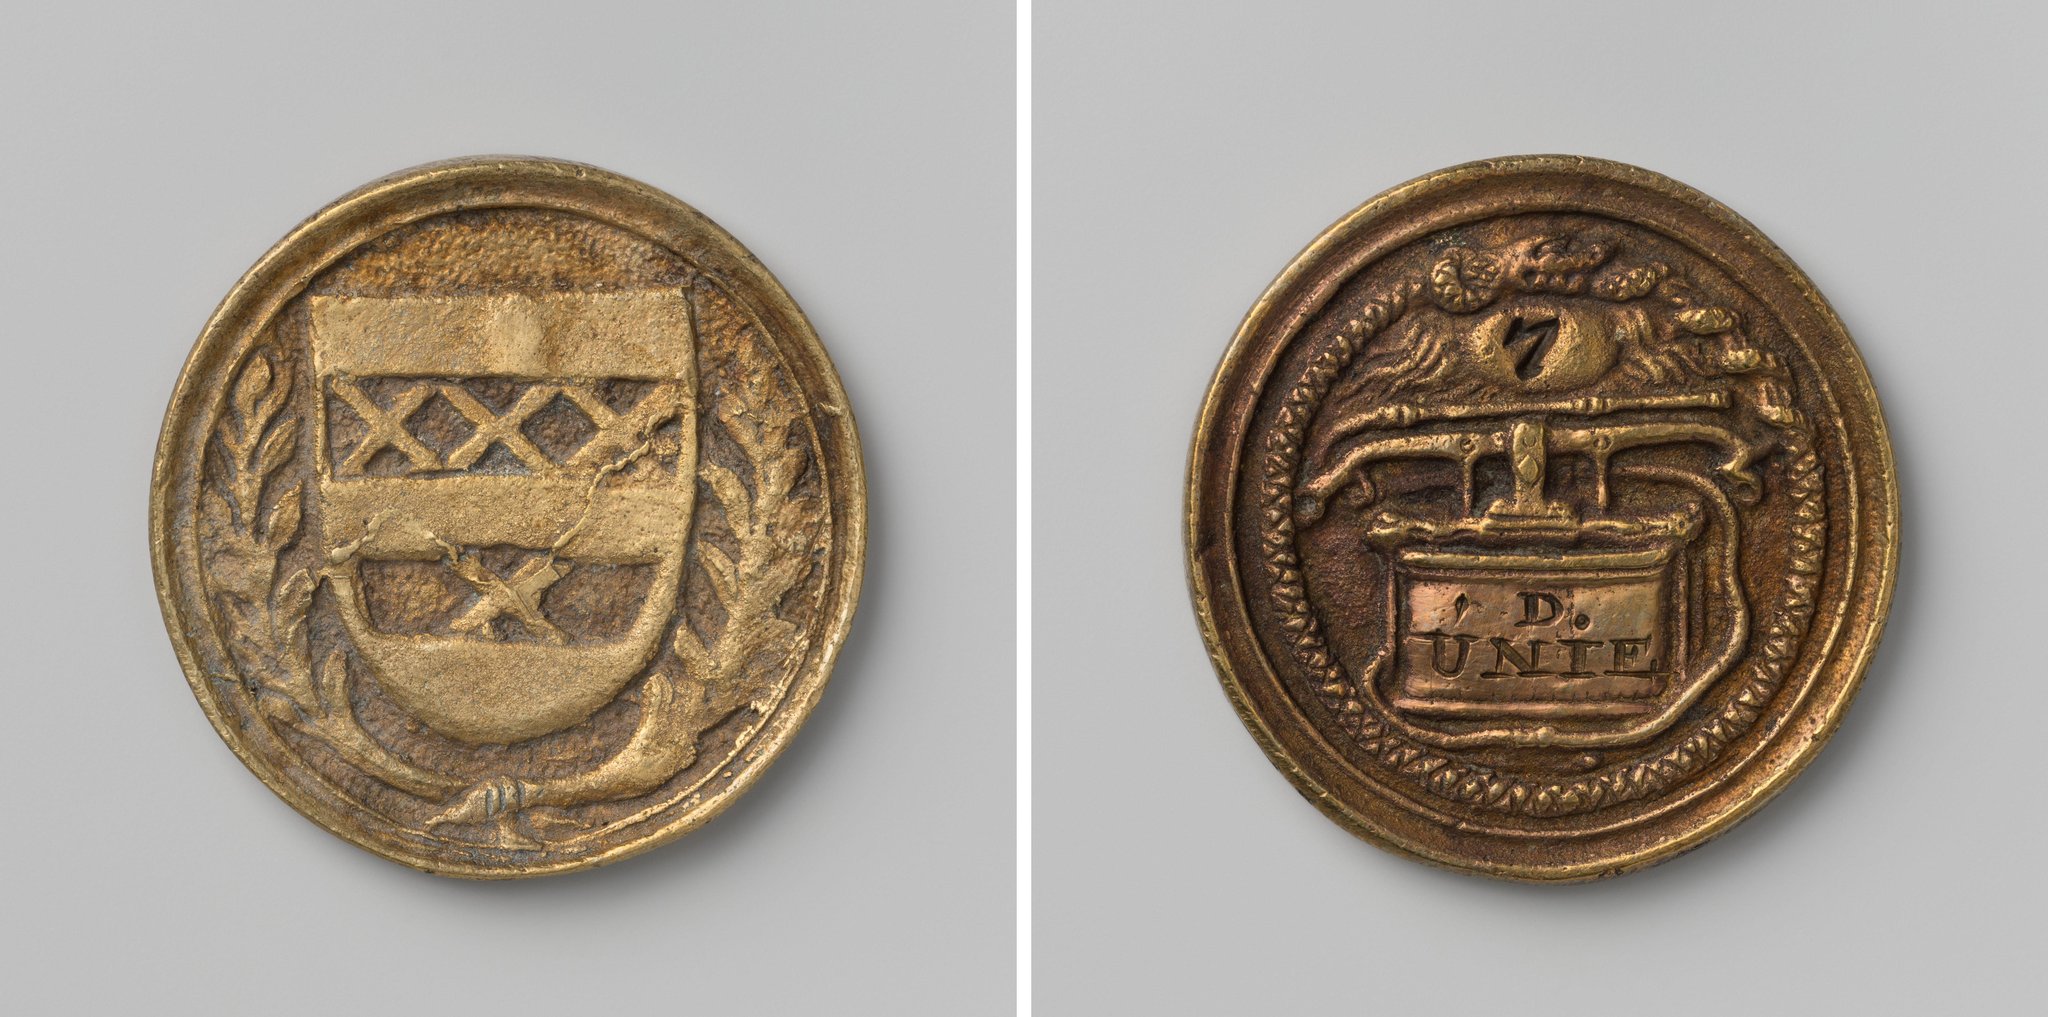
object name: fire engine medal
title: Nieuwer Amstel, brandspuitpenning met opschrift D. Unie en no. 7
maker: Anonymous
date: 1680-1800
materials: brass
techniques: casting, engraving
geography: amsterdam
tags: nieuwer-amstel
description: Messing penning. Voorzijde: wapenschild binnen bladertakken. Keerzijde: brandspuit onder cartouche met no. 7 binnen slangerond; 1